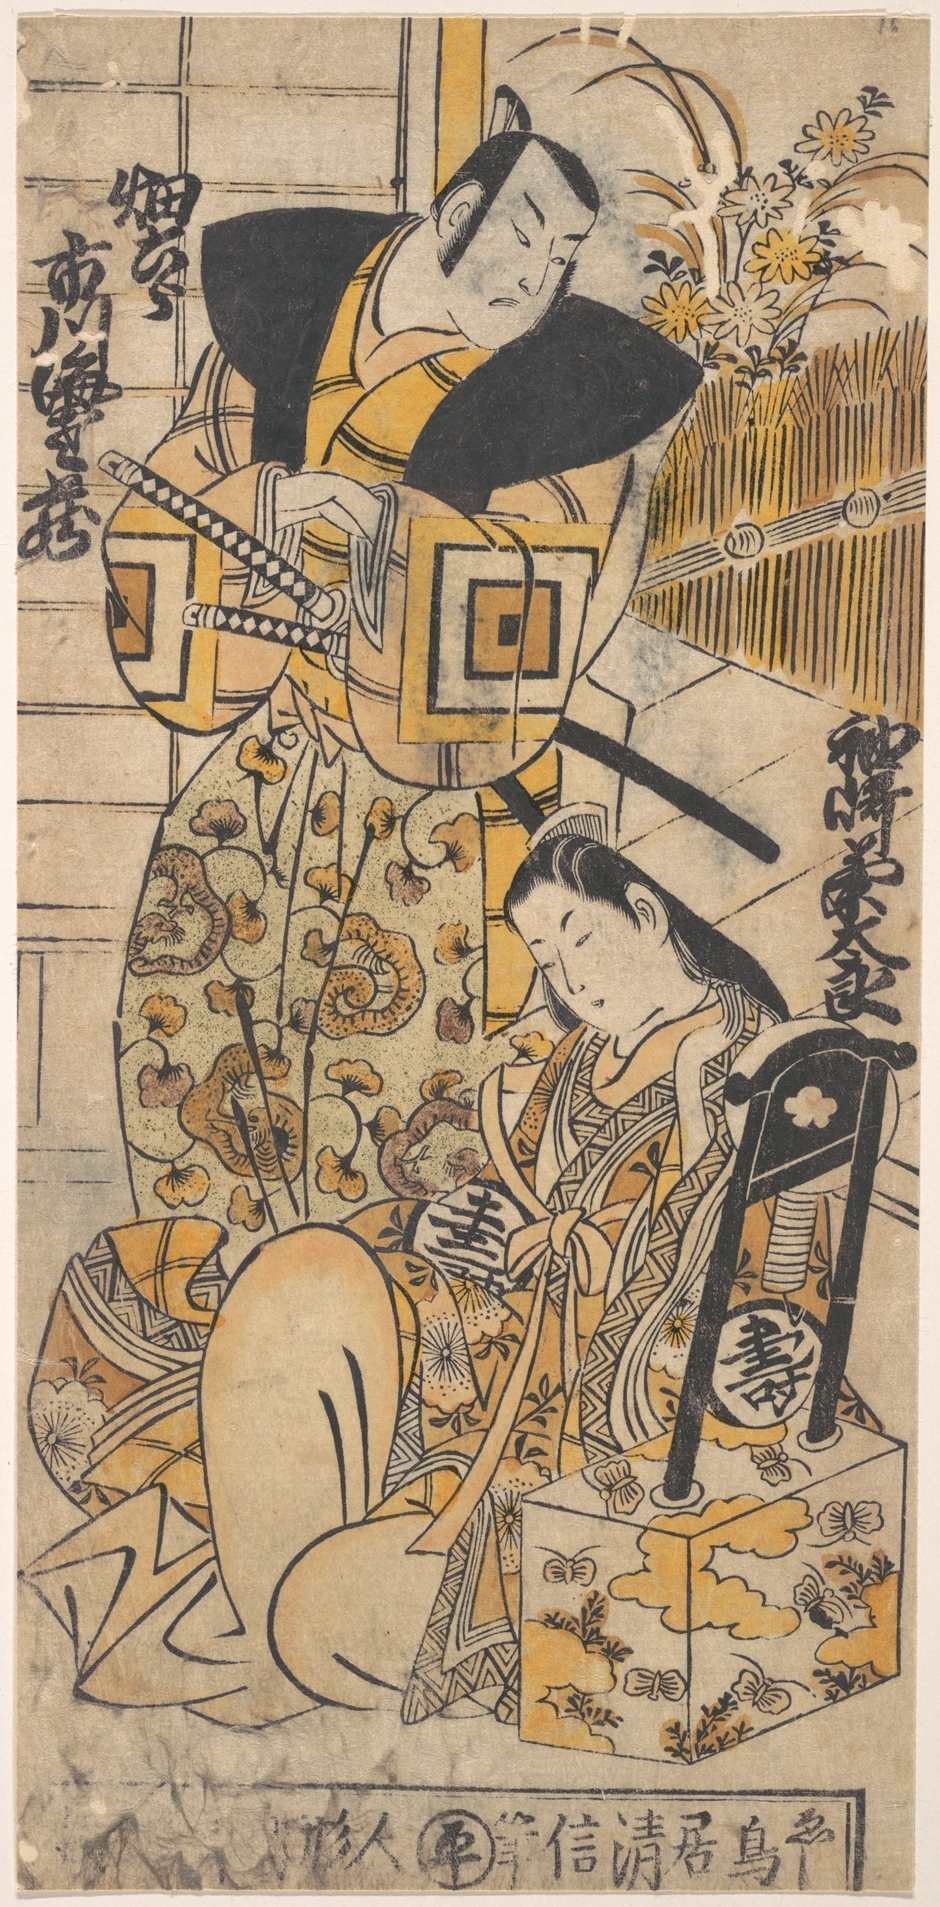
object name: print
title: The Actor, Ichikawa Danjuro I, 1660–1704 as a Woman in Unidentified Role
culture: japanese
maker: torii kiyonobu i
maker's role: artist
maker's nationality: japanese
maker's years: 1664-1729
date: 1664-1729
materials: ink, paper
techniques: woodblock print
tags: swords,men,women,actors